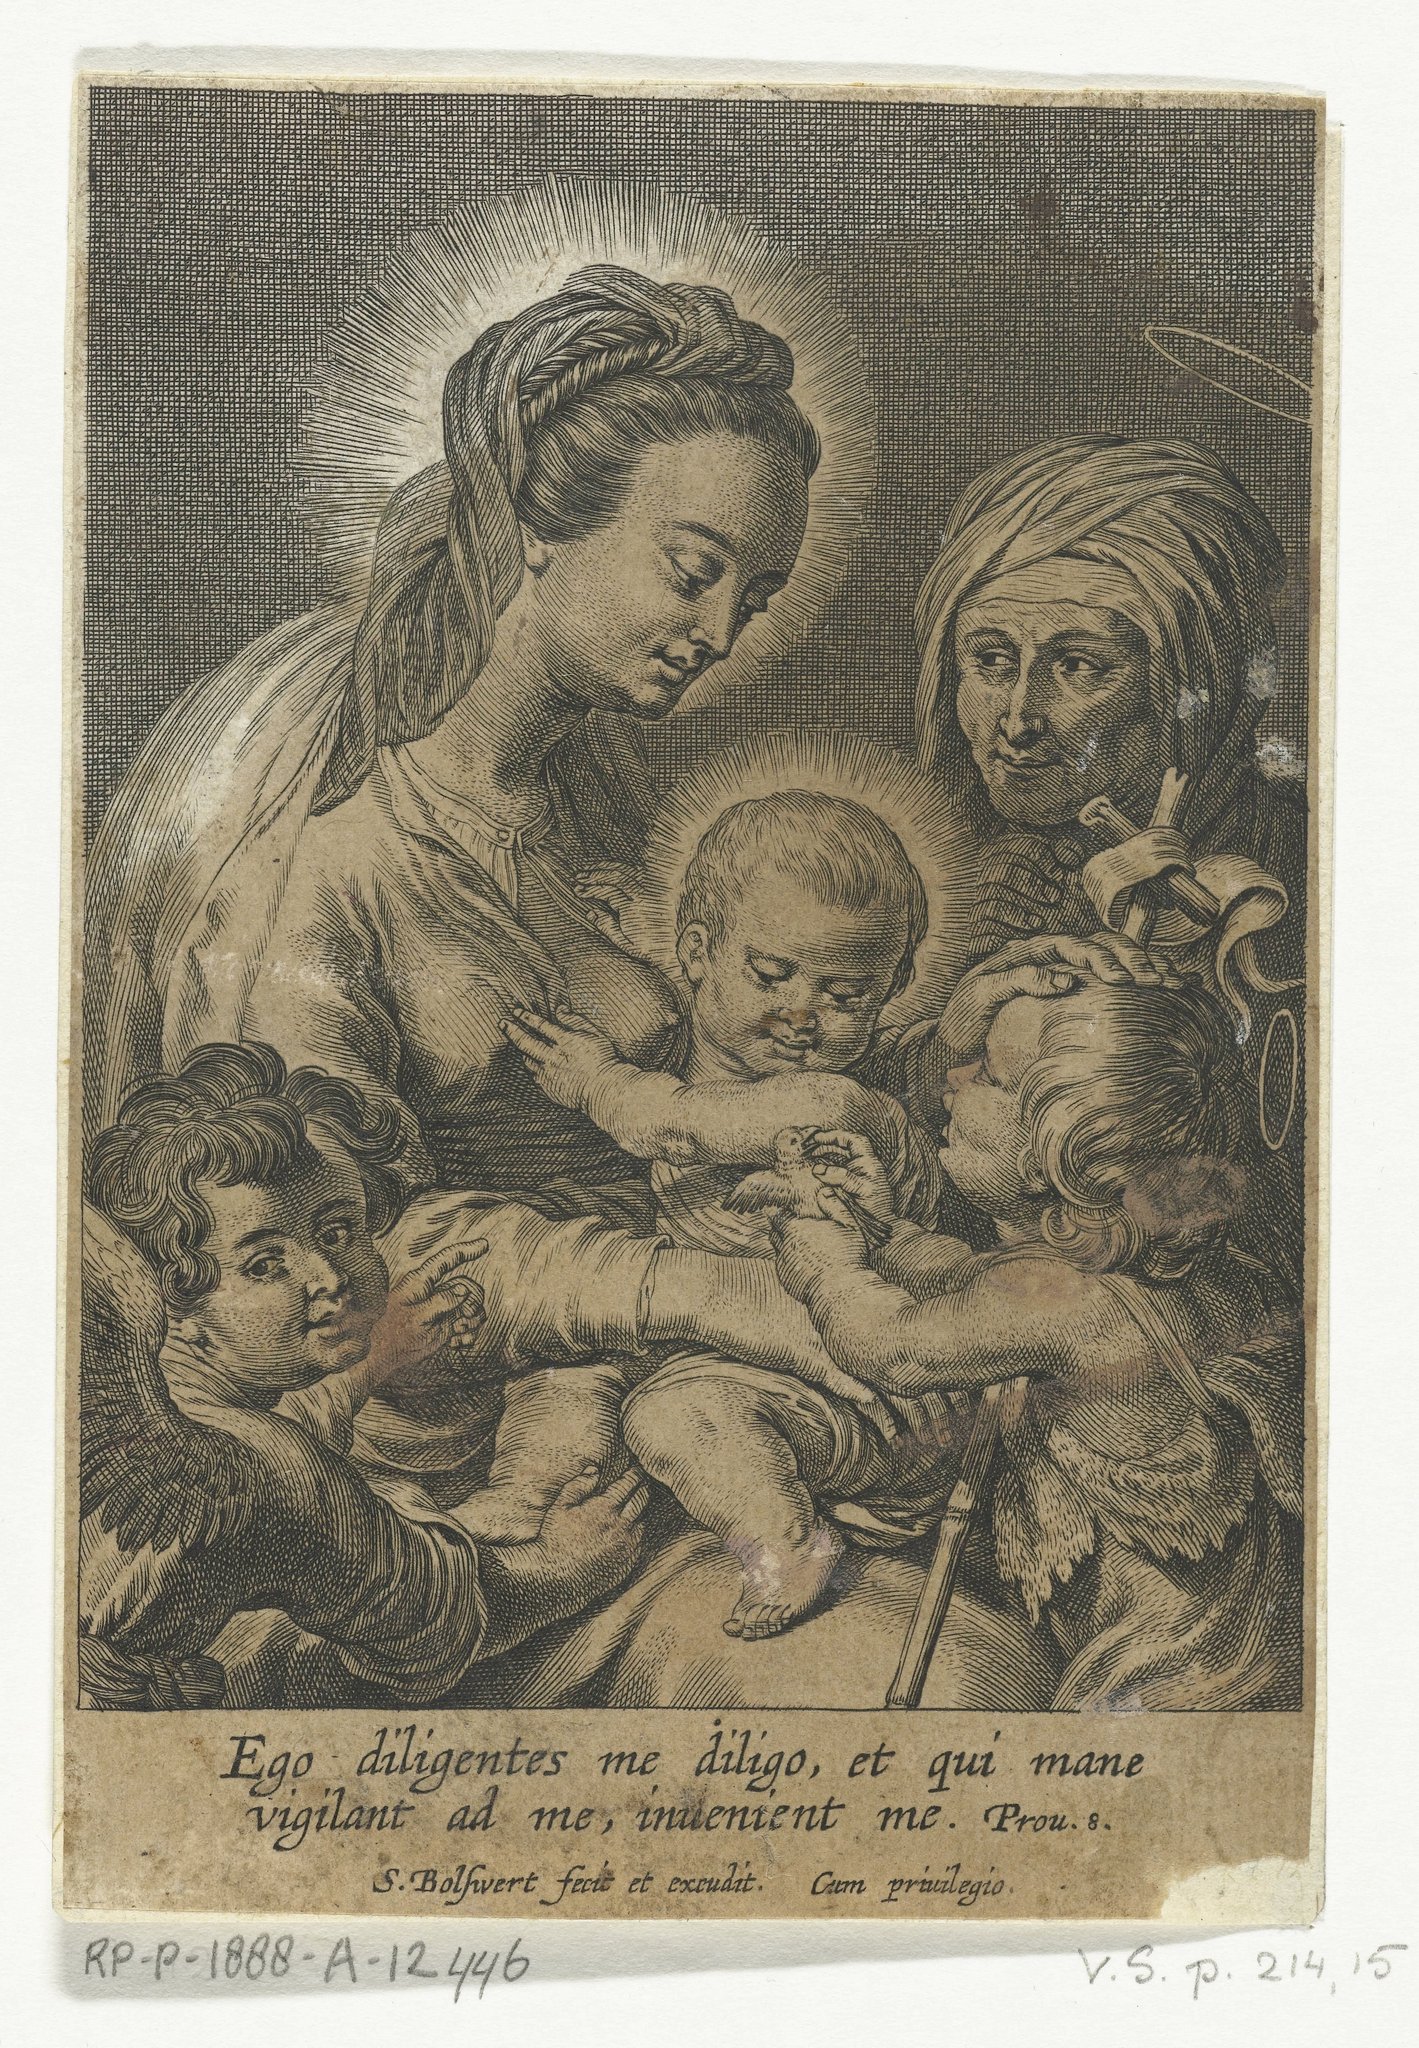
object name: print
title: Maria met Kind en Johannes de Doper als kind met Anna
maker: schelte adamsz. bolswert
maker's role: print maker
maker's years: 1586-1659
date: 1596-1659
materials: paper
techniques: engraving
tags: christ-child holding something in his hand, e.g. apple, bird, cherries, crucifix, grapes, paper wind-mill ~ madonna-representations, anna, mother of mary; possible attributes: book, christ-child, lily, virgin mary, mary, the christ-child and john the baptist (as child) with others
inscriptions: collector's mark: Lugt 2228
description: Prent uit serie Vélins met negentig prenten naar ontwerp van Peter Paul Rubens. In de bronnen vinden we uiteenlopende gegevens over aantal en samenstelling van de serie. Hollstein hanteert het aantal van negentig prenten. De reeks Vélins in de collectie van het RMA bevat verschillende staten afkomstig uit meerdere uitgaven welke moeilijk te duiden zijn. Sommige dragen het originele adres van Schelte Adamsz. Bolswert als graveur en uitgever, op andere exemplaren is deze naam verwijderd (duidelijk zichtbaar!) en vervangen door de naam Cornelis Galle (II). De prenten met de naam van uitgever Galle zijn vaak opgewerkt. We treffen nog een andere naam van een uitgever bij enkele prent aan: Martien van den Enden. Herkomst uit meerdere uitgaven spreekt ook uit afwijkende opschriften in Nederlands en Latijn en variaties op dezelfde thema's welke misschien nooit langs elkaar in dezelfde serie gebruikt werden.